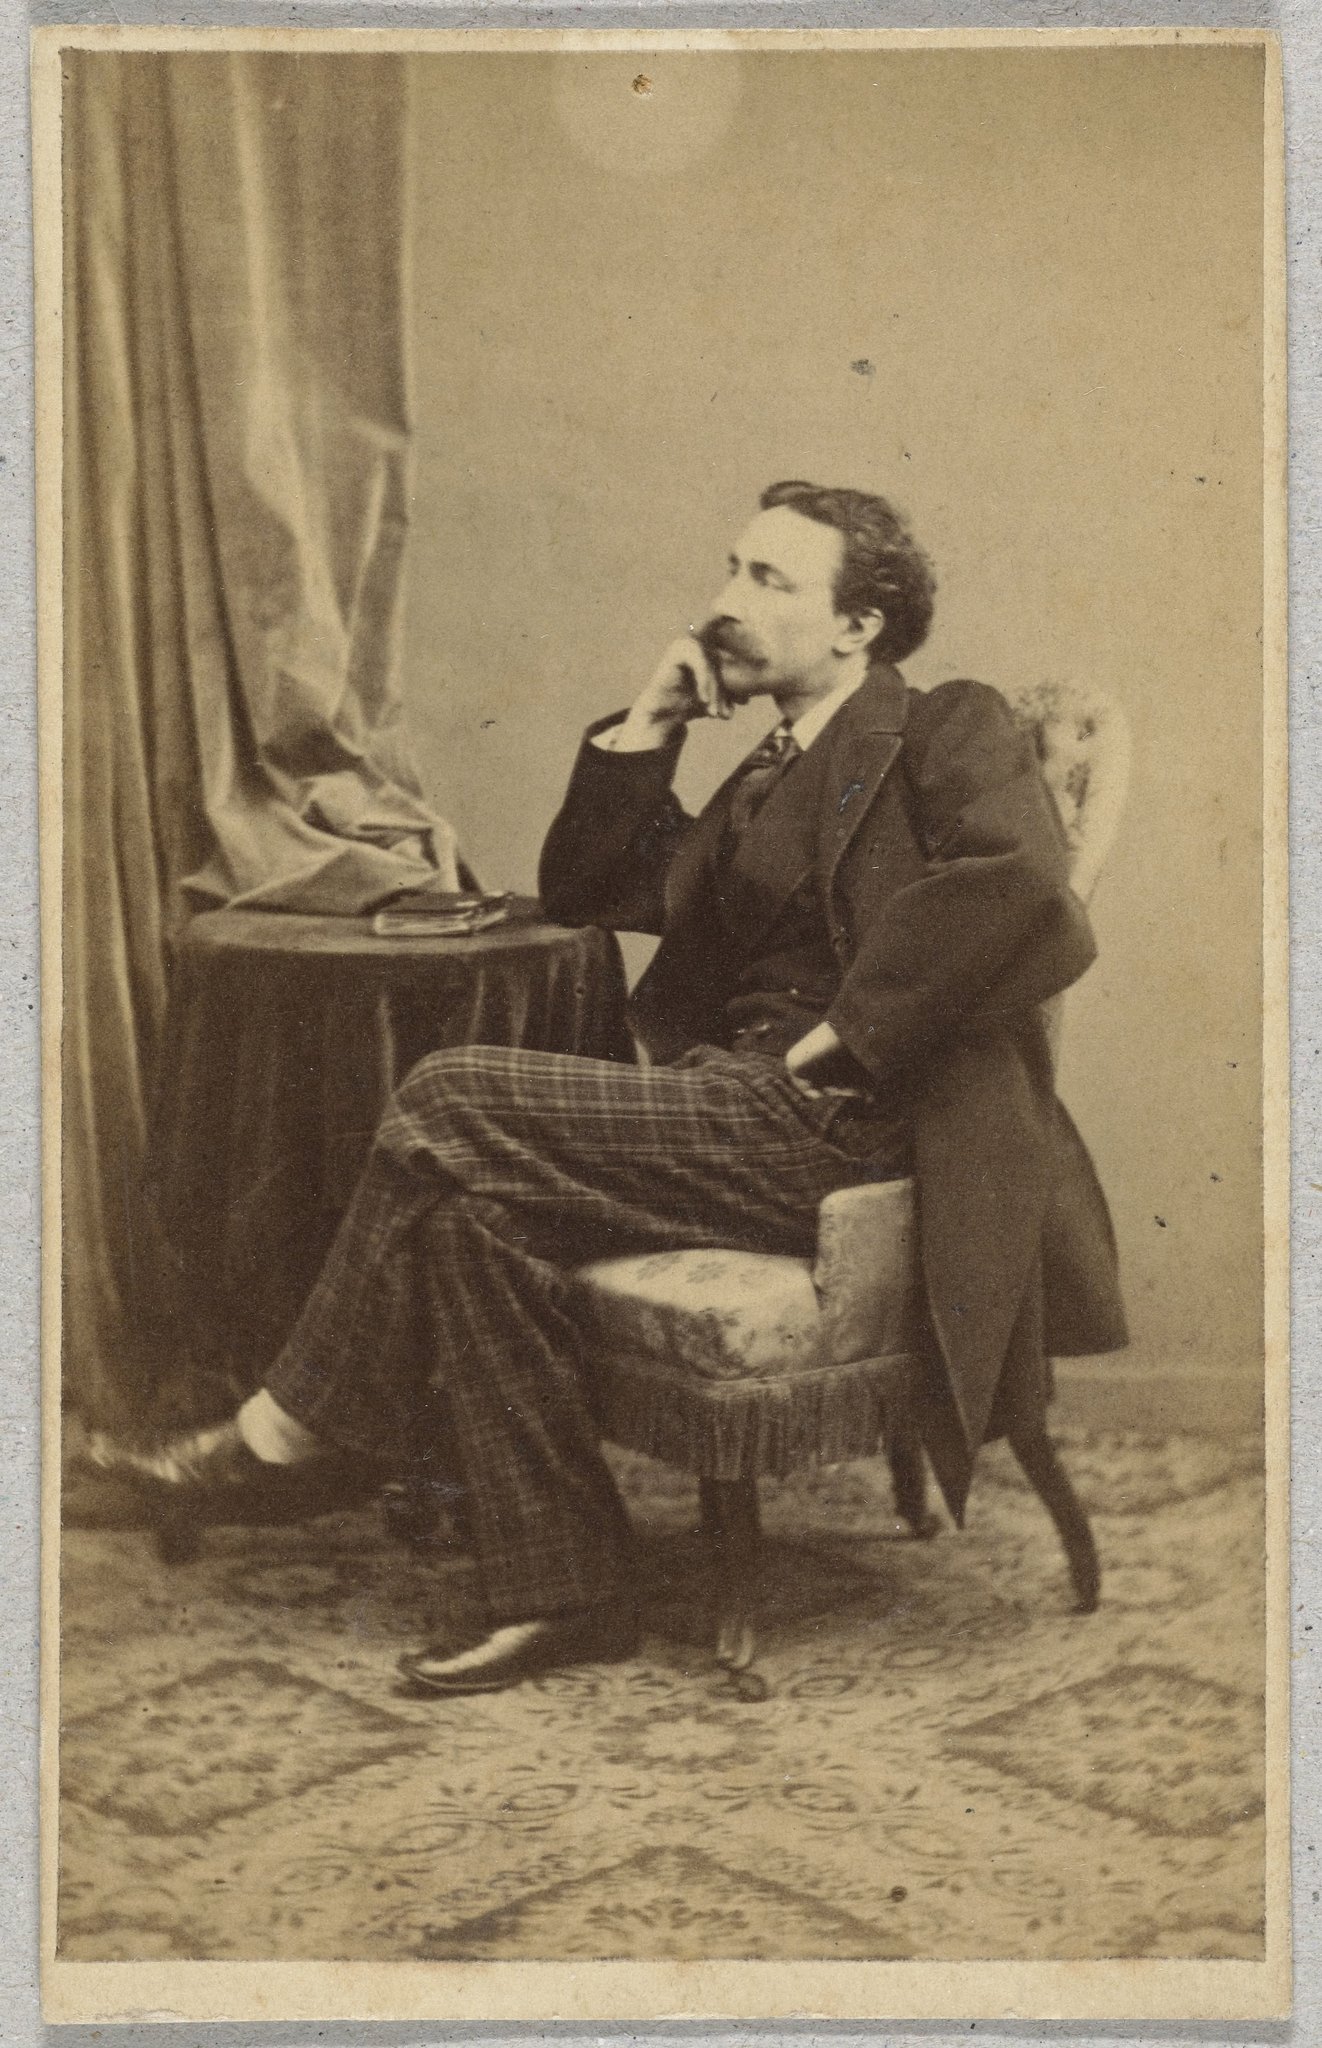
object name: carte de visite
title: Elchanon Verveer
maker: maurits verveer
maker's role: painter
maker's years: 1817-1903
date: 1857-1875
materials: cardboard, paper, photographic support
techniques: albumen print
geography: the hague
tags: the hague, print maker, draughtsman, elchanon verveer, historical persons, artist in non-work situation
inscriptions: annotation: ‘Elchanon Verveer’, name: ‘M. Verveer, photographe Zeestraat vis-a-vis du Willemspark La Haye’